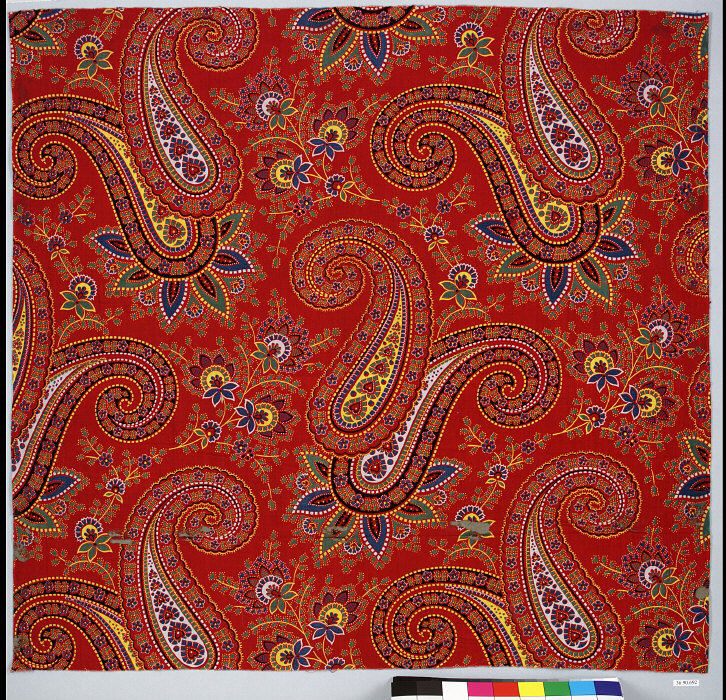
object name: piece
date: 1867-1900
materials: cotton